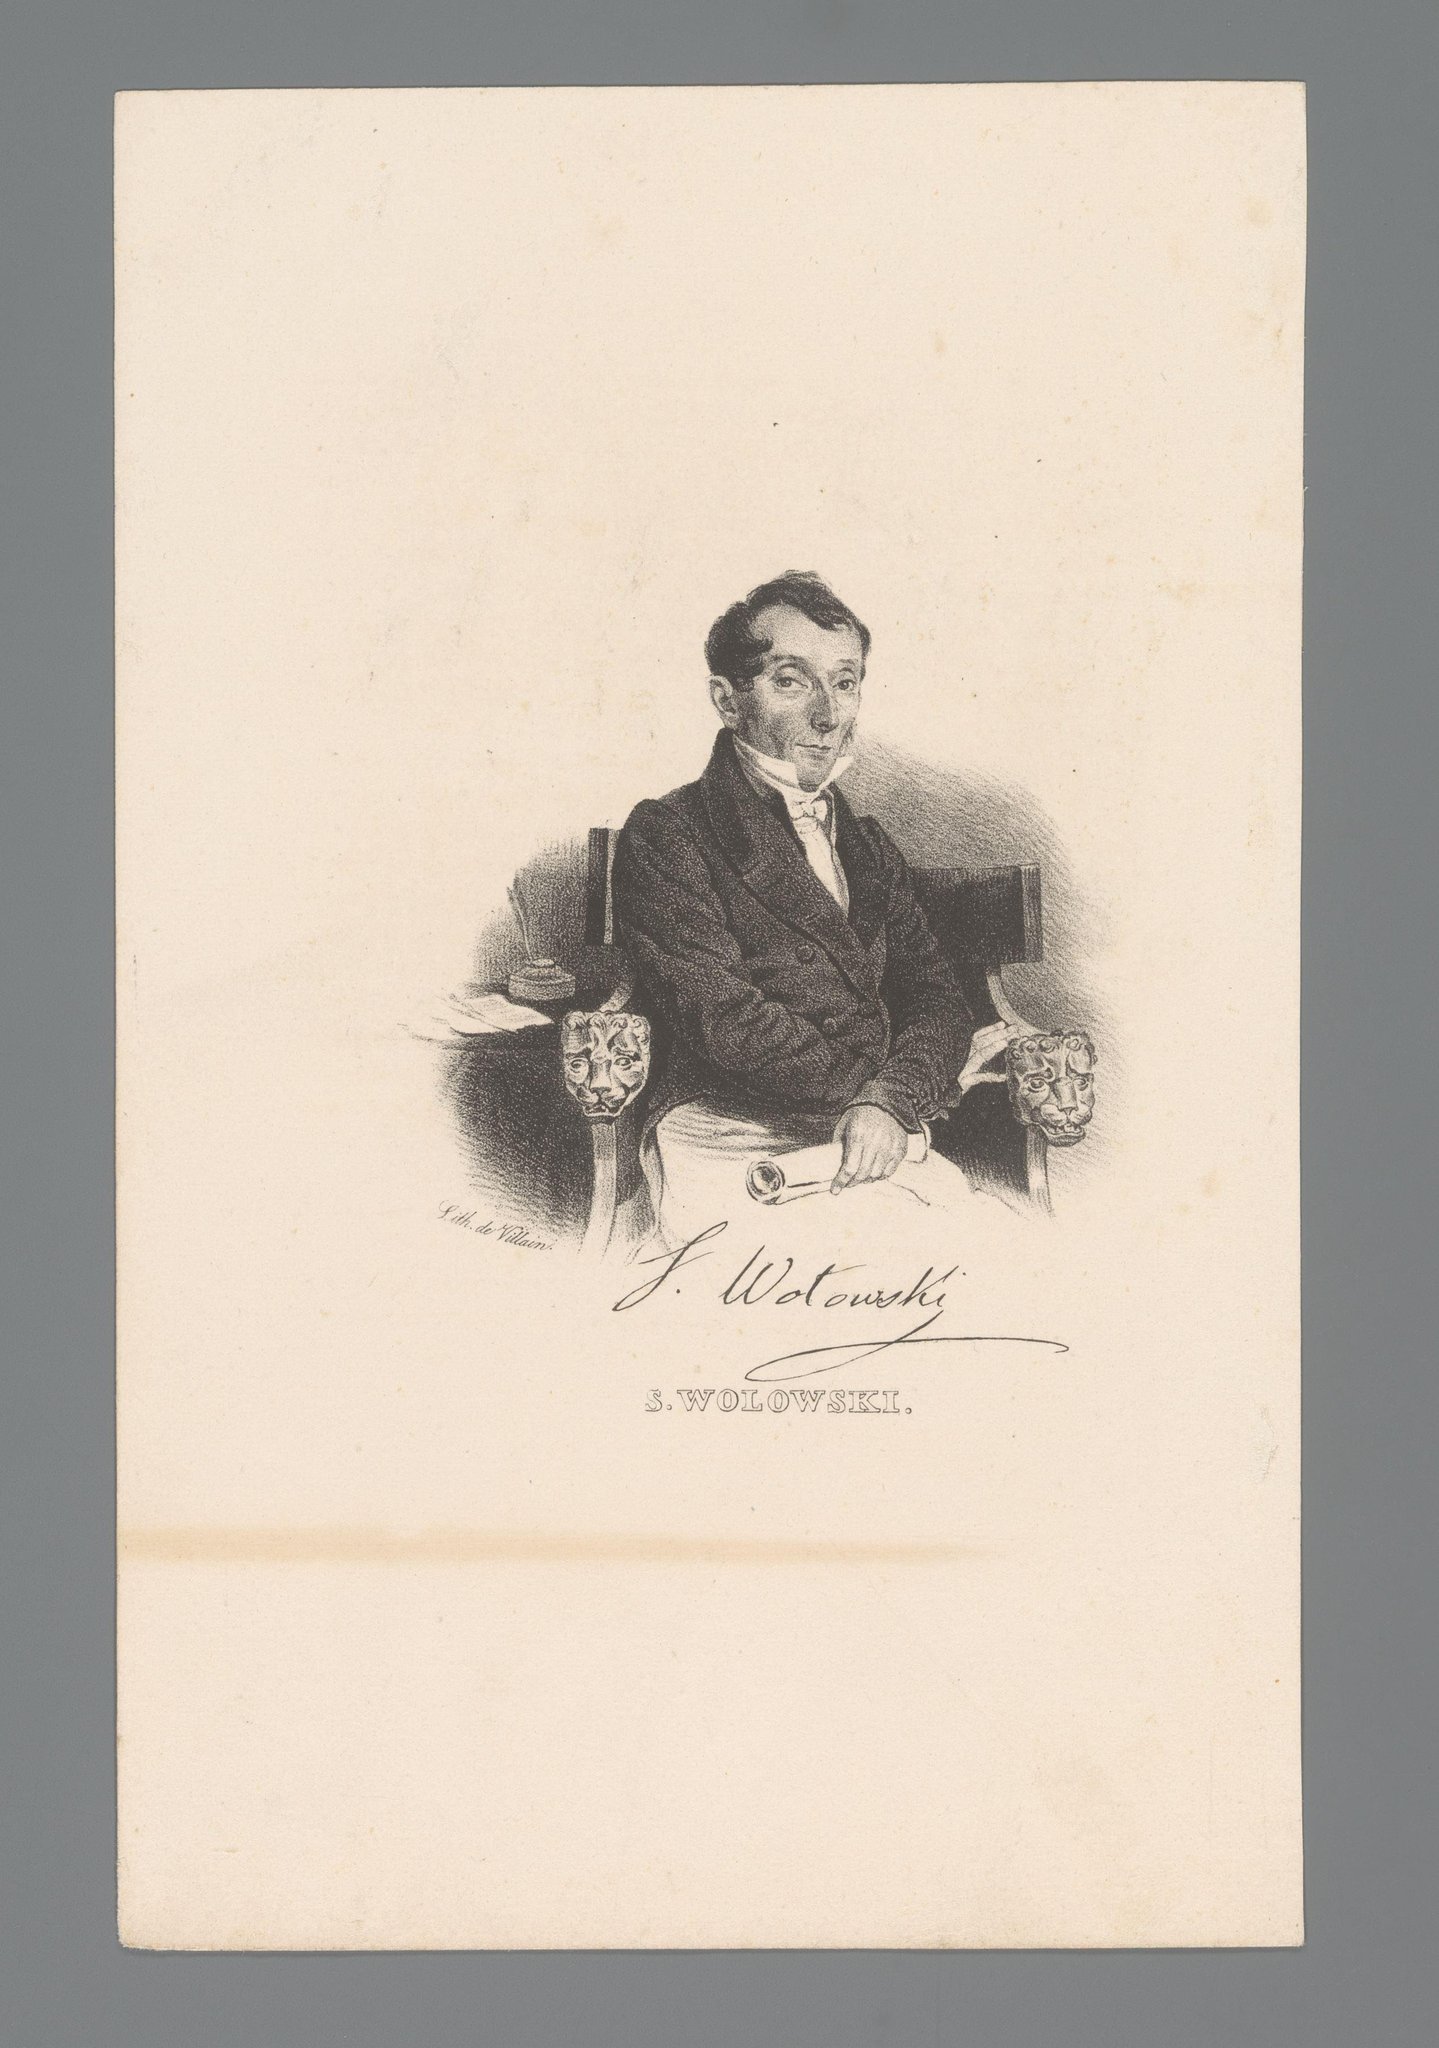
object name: book illustration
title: S. Wolowski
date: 1832-1839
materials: paper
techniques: lithograph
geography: paris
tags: paris, politician, historical persons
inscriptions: collector's mark: Lugt 2228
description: Prent uit: Straszewicz., Joseph. Les polonais et les polonaises de la révolution du 29 novembre 1830, ou Portraits des personnes qui ont figuré dans la dernière guerre de l'indépendance polonaise, avec les fac-simile de leur signature, lithographiés sur dessins originaux, par les artistes les plus distingués: MM. Grévedon, Maurin, Vigneron, Belliard, Devéria, Bazin, Desmadryl, Lecler, Desmaisons, Rutowski, officier polonais, etc,. etc., accompagnés d'une biographie pour chaque portrait. Parijs: Catherine-Anaïs Pinard, 1832. Of uit: Straszewicz., Joseph. Les polonais et les polonaises de la révolution du 29 novembre 1830. Biographie des personnes qui ont figuré dans la dernière guerre de l'indépendance polonaise, avec les fac-simile de leur signature, ornée de 30 portraits lithographiés sur dessins originaux, par les artistes les plus distingués: MM. Grévedon, Maurin, Vigneron, Belliard, Devéria, Bazin, Desmadryl, Lecler, etc., etc.. Parijs: s.n., 1839.